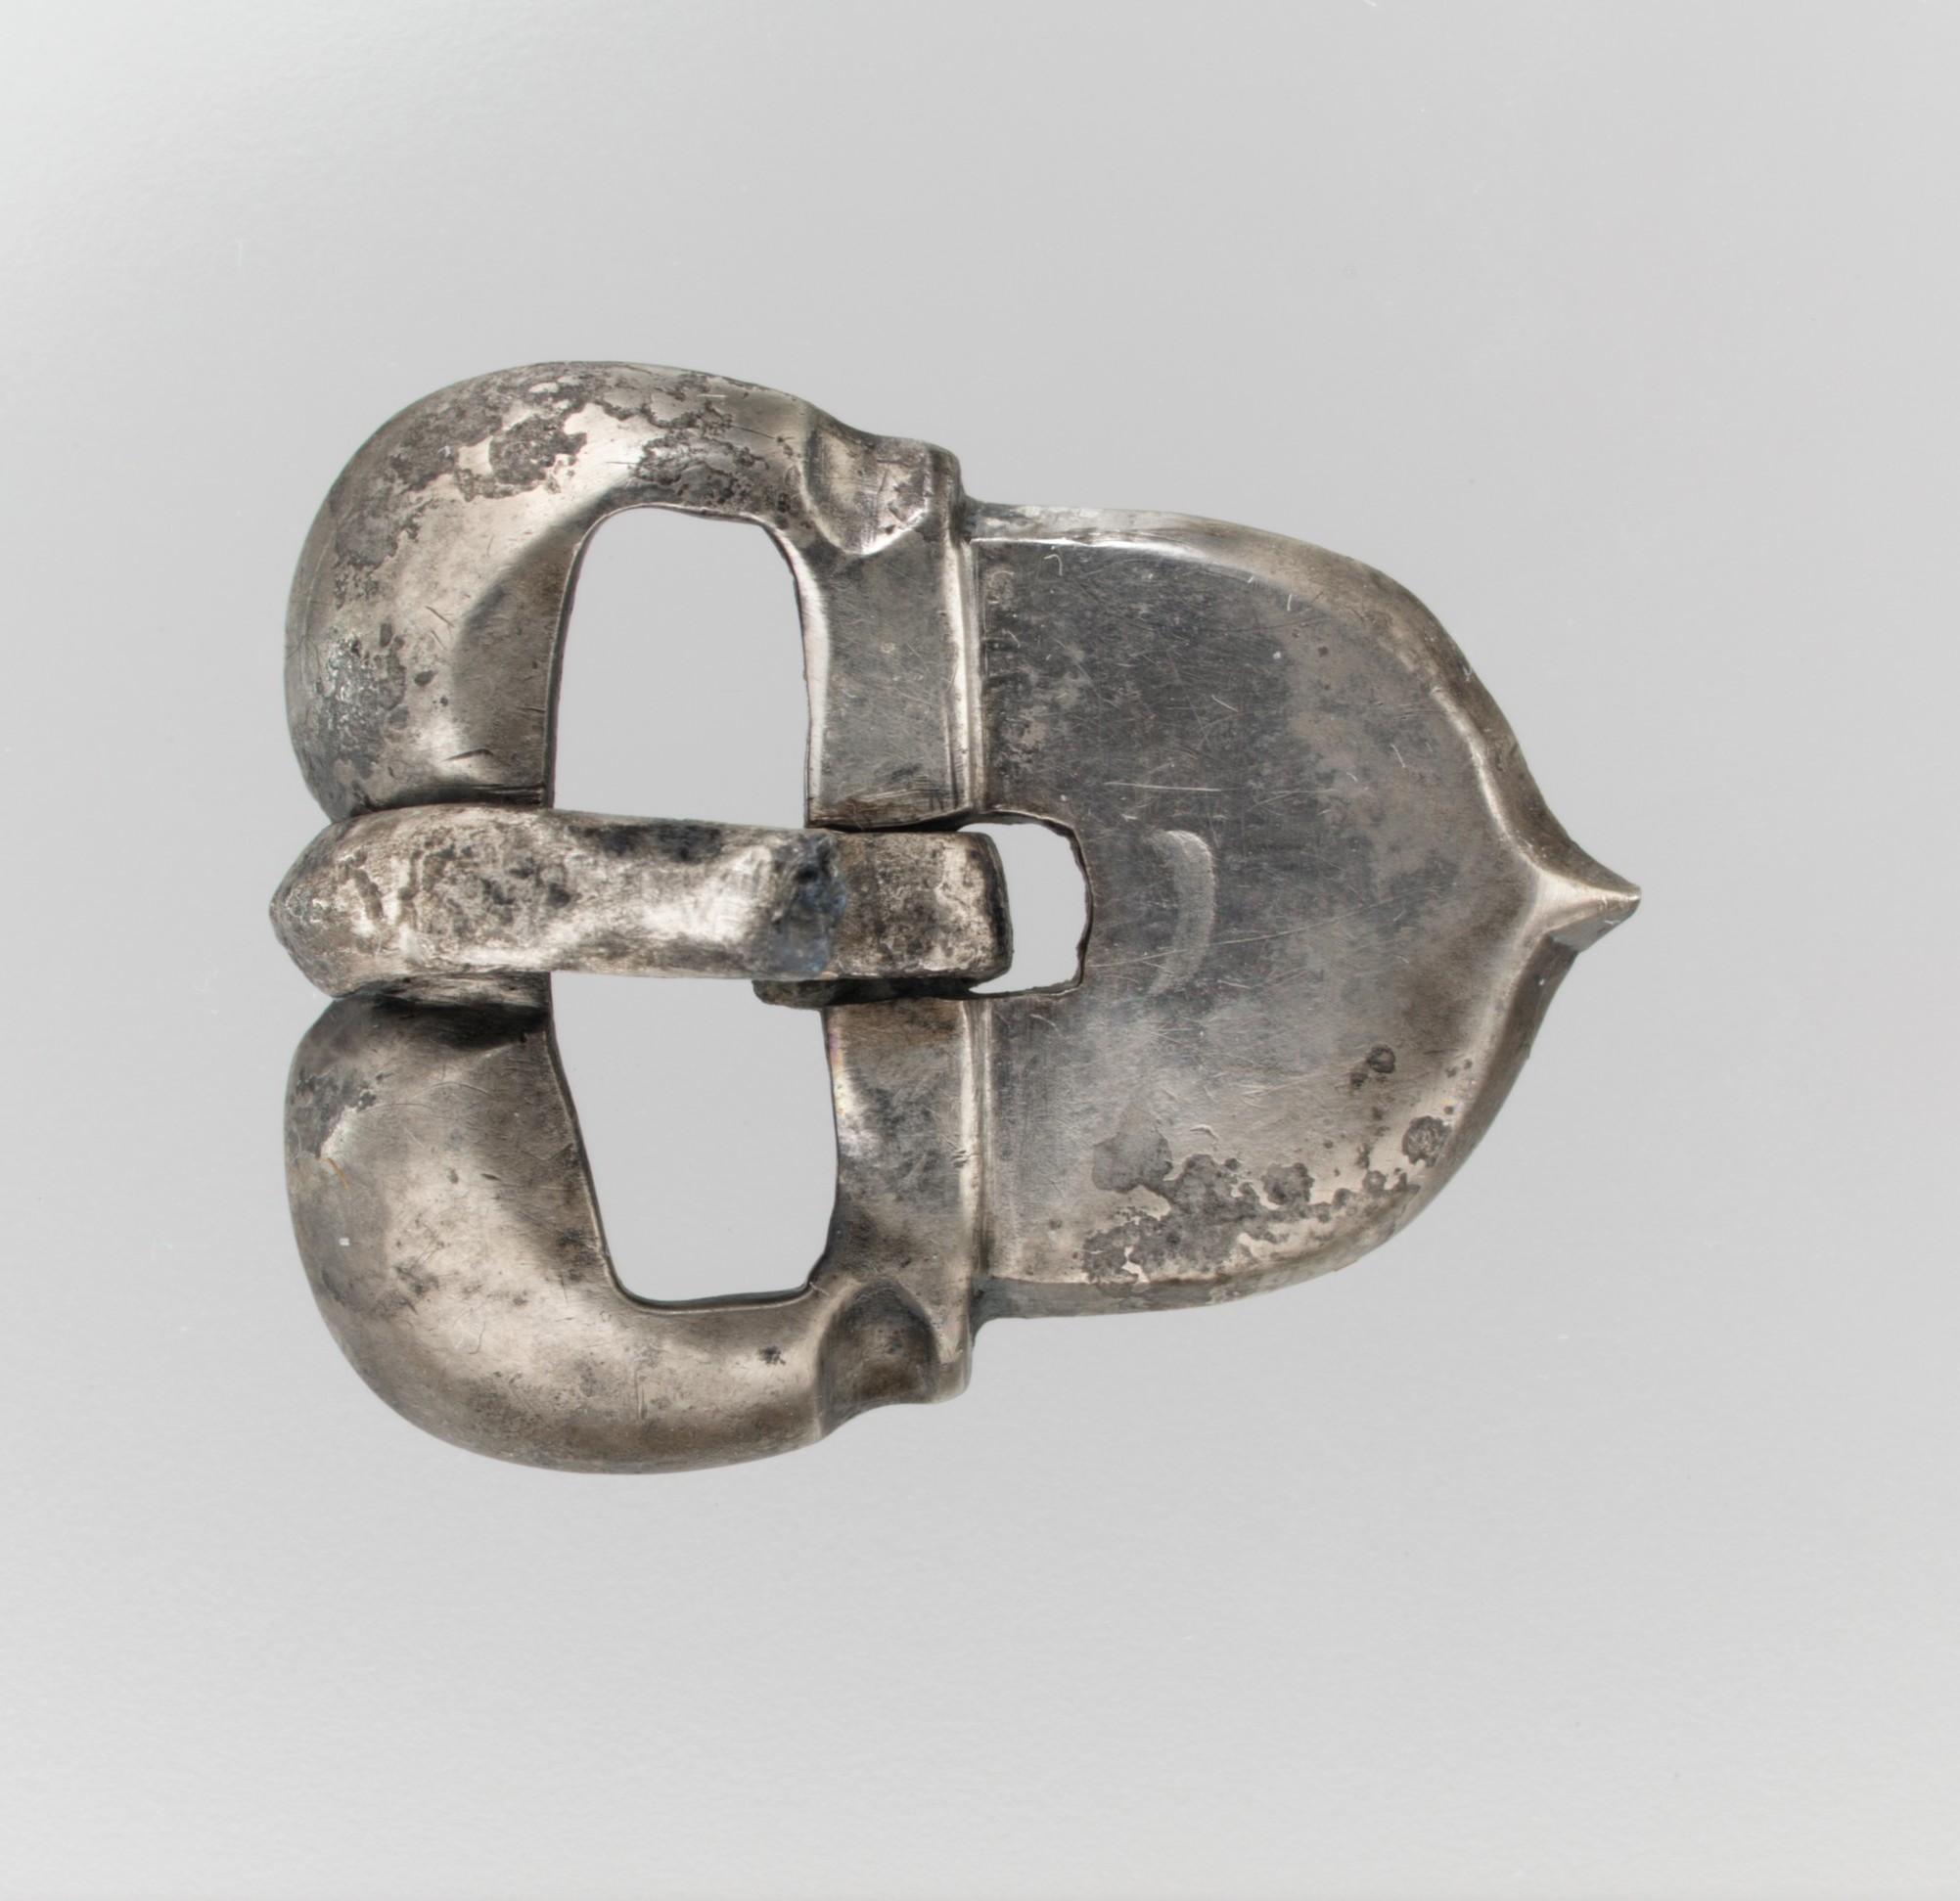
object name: shoe buckle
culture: byzantine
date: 601-700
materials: silver